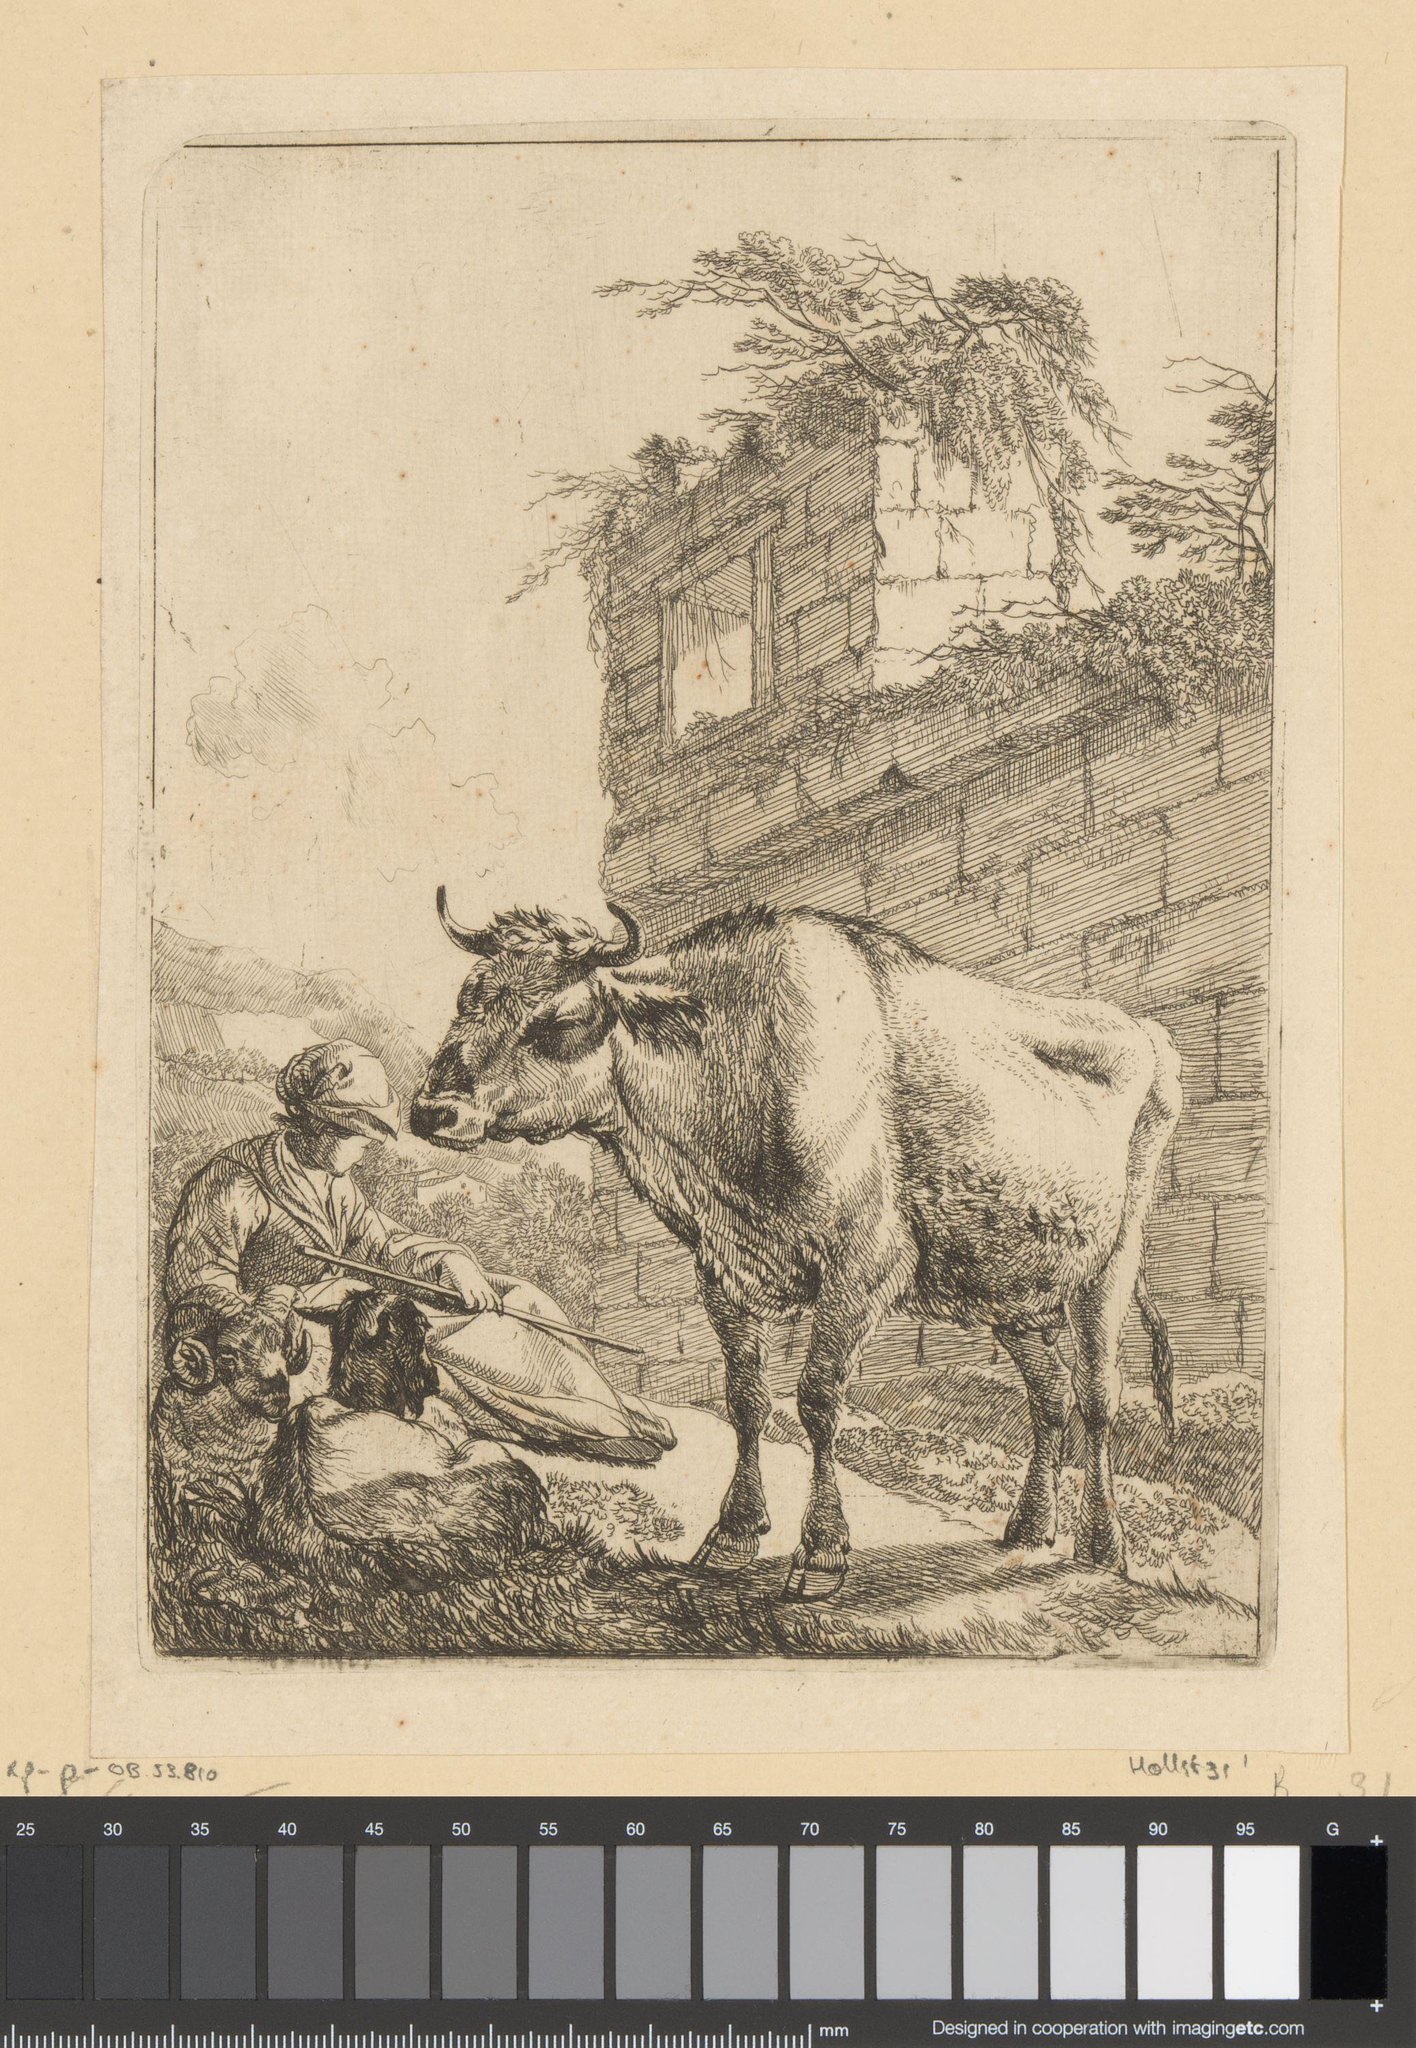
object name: print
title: Zittende herderin met koe, geit en ram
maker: johann heinrich roos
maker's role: draughtsman, print maker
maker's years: 1631-1685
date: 1641-1685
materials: paper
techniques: etching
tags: cow, herding, herdsman, herdswoman, shepherd, shepherdess, cowherd, etc., ram, landscape with ruins, goat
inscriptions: collector's mark: Lugt 240